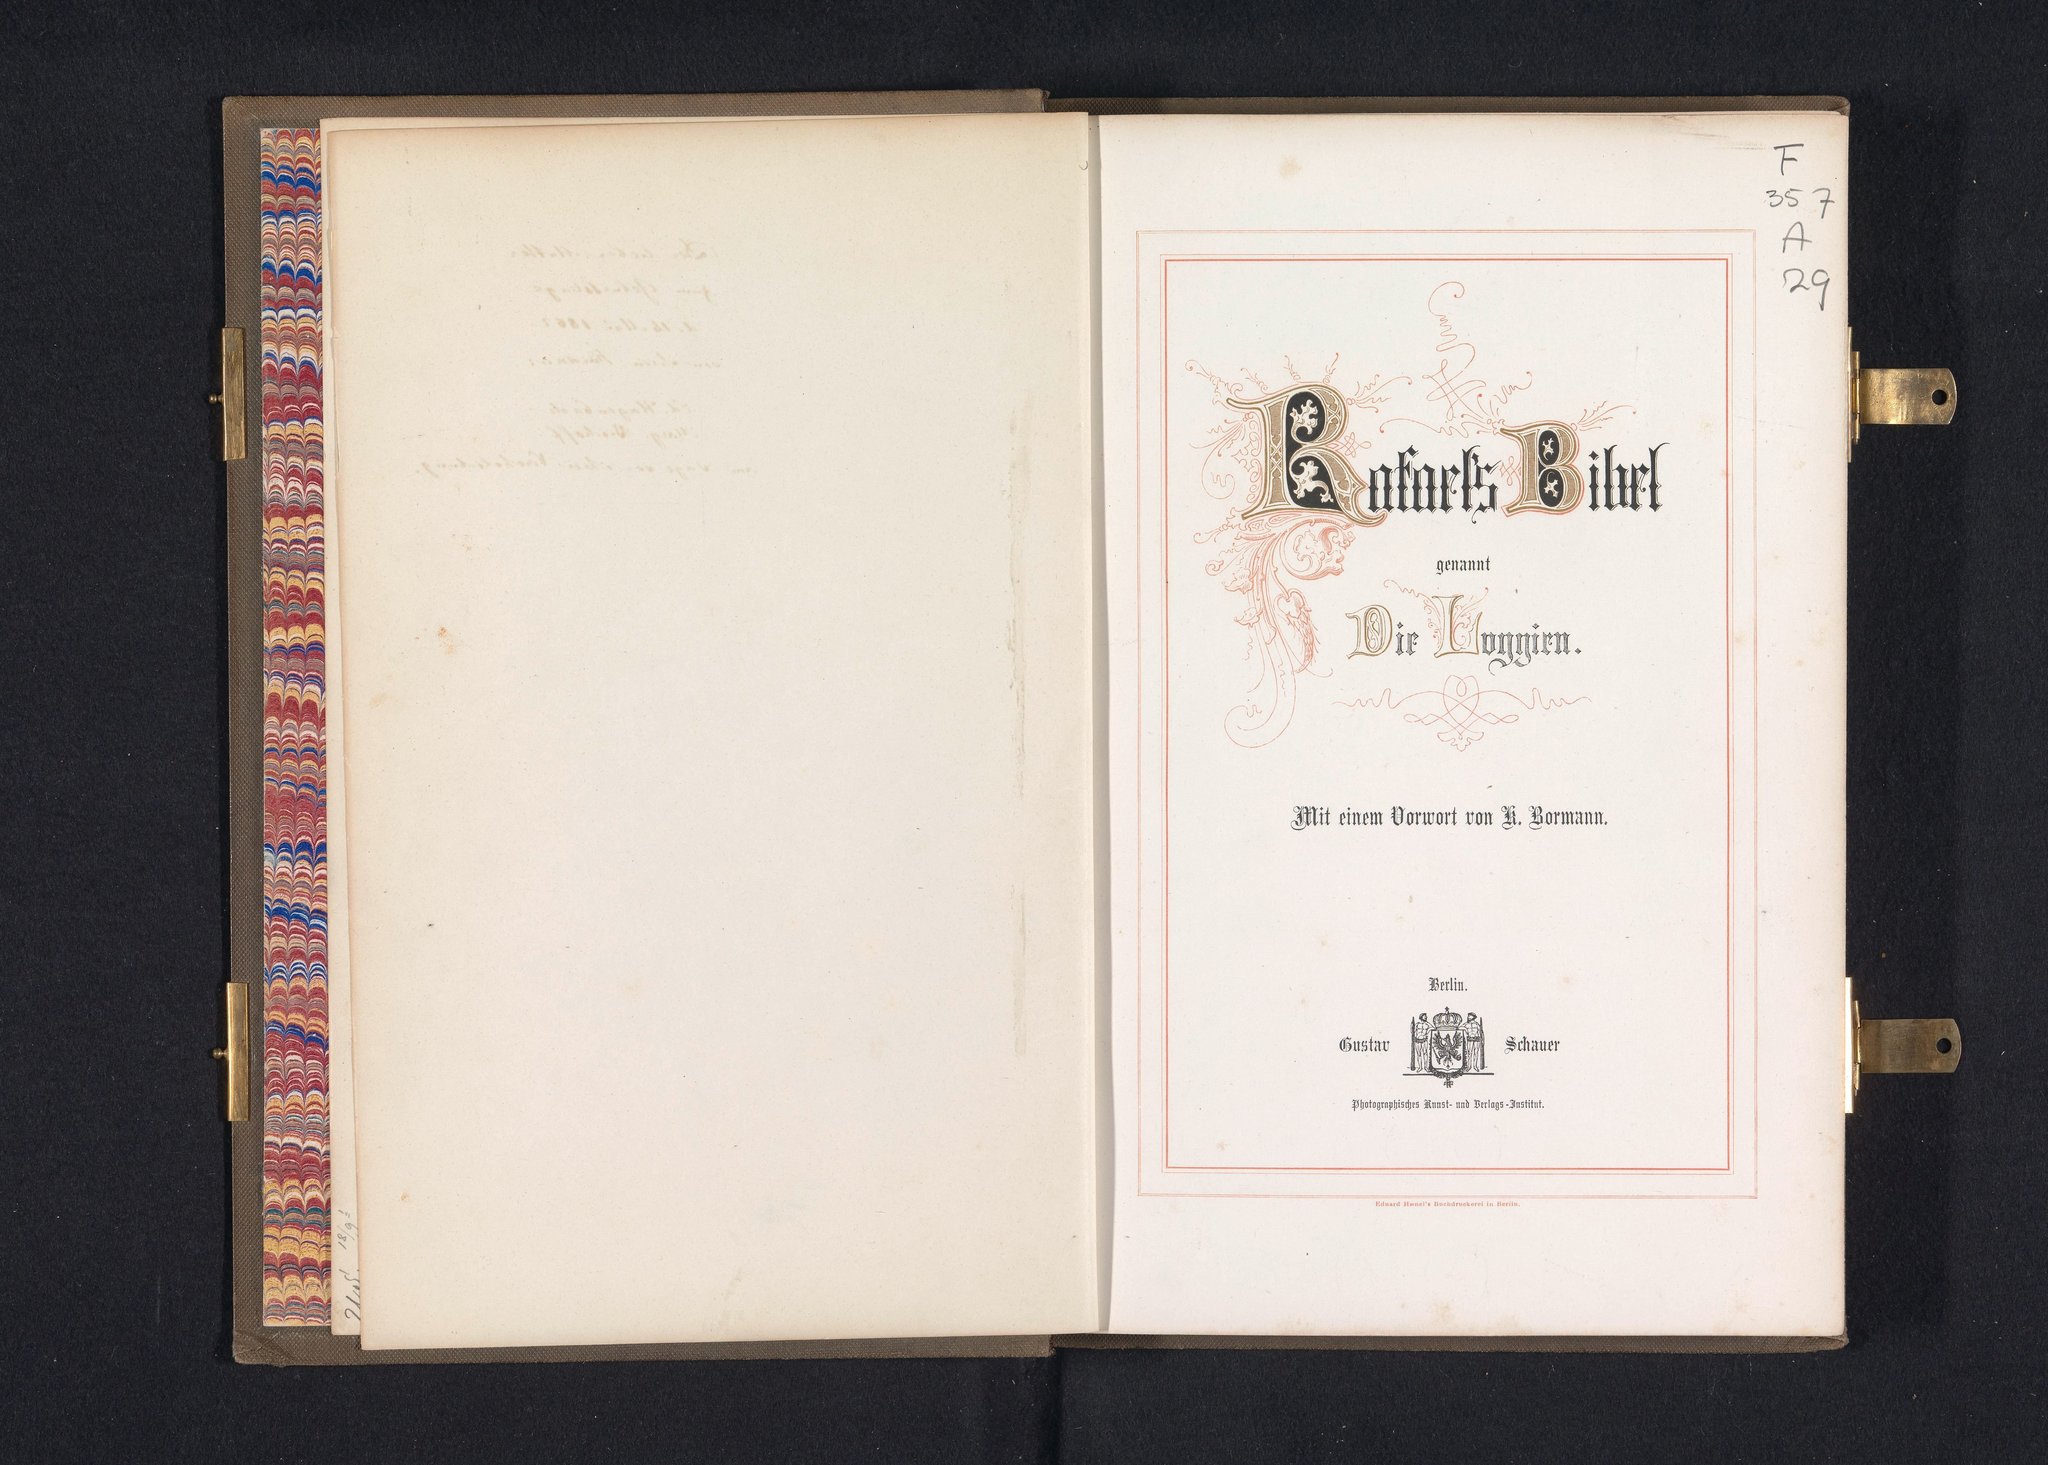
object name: book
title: Rafael's Bibel genannt die Loggien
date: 1861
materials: cardboard, linen, paper, photographic support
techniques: albumen print, marbled paper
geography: berlin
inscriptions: inscription: ‘Der lieben Mutter zim Geburtstage d. 14 Mai 1862 von ihren Kindern: Ed. Hagenbach Mar. Bischoff am Tage vor ihre Verehlichung’